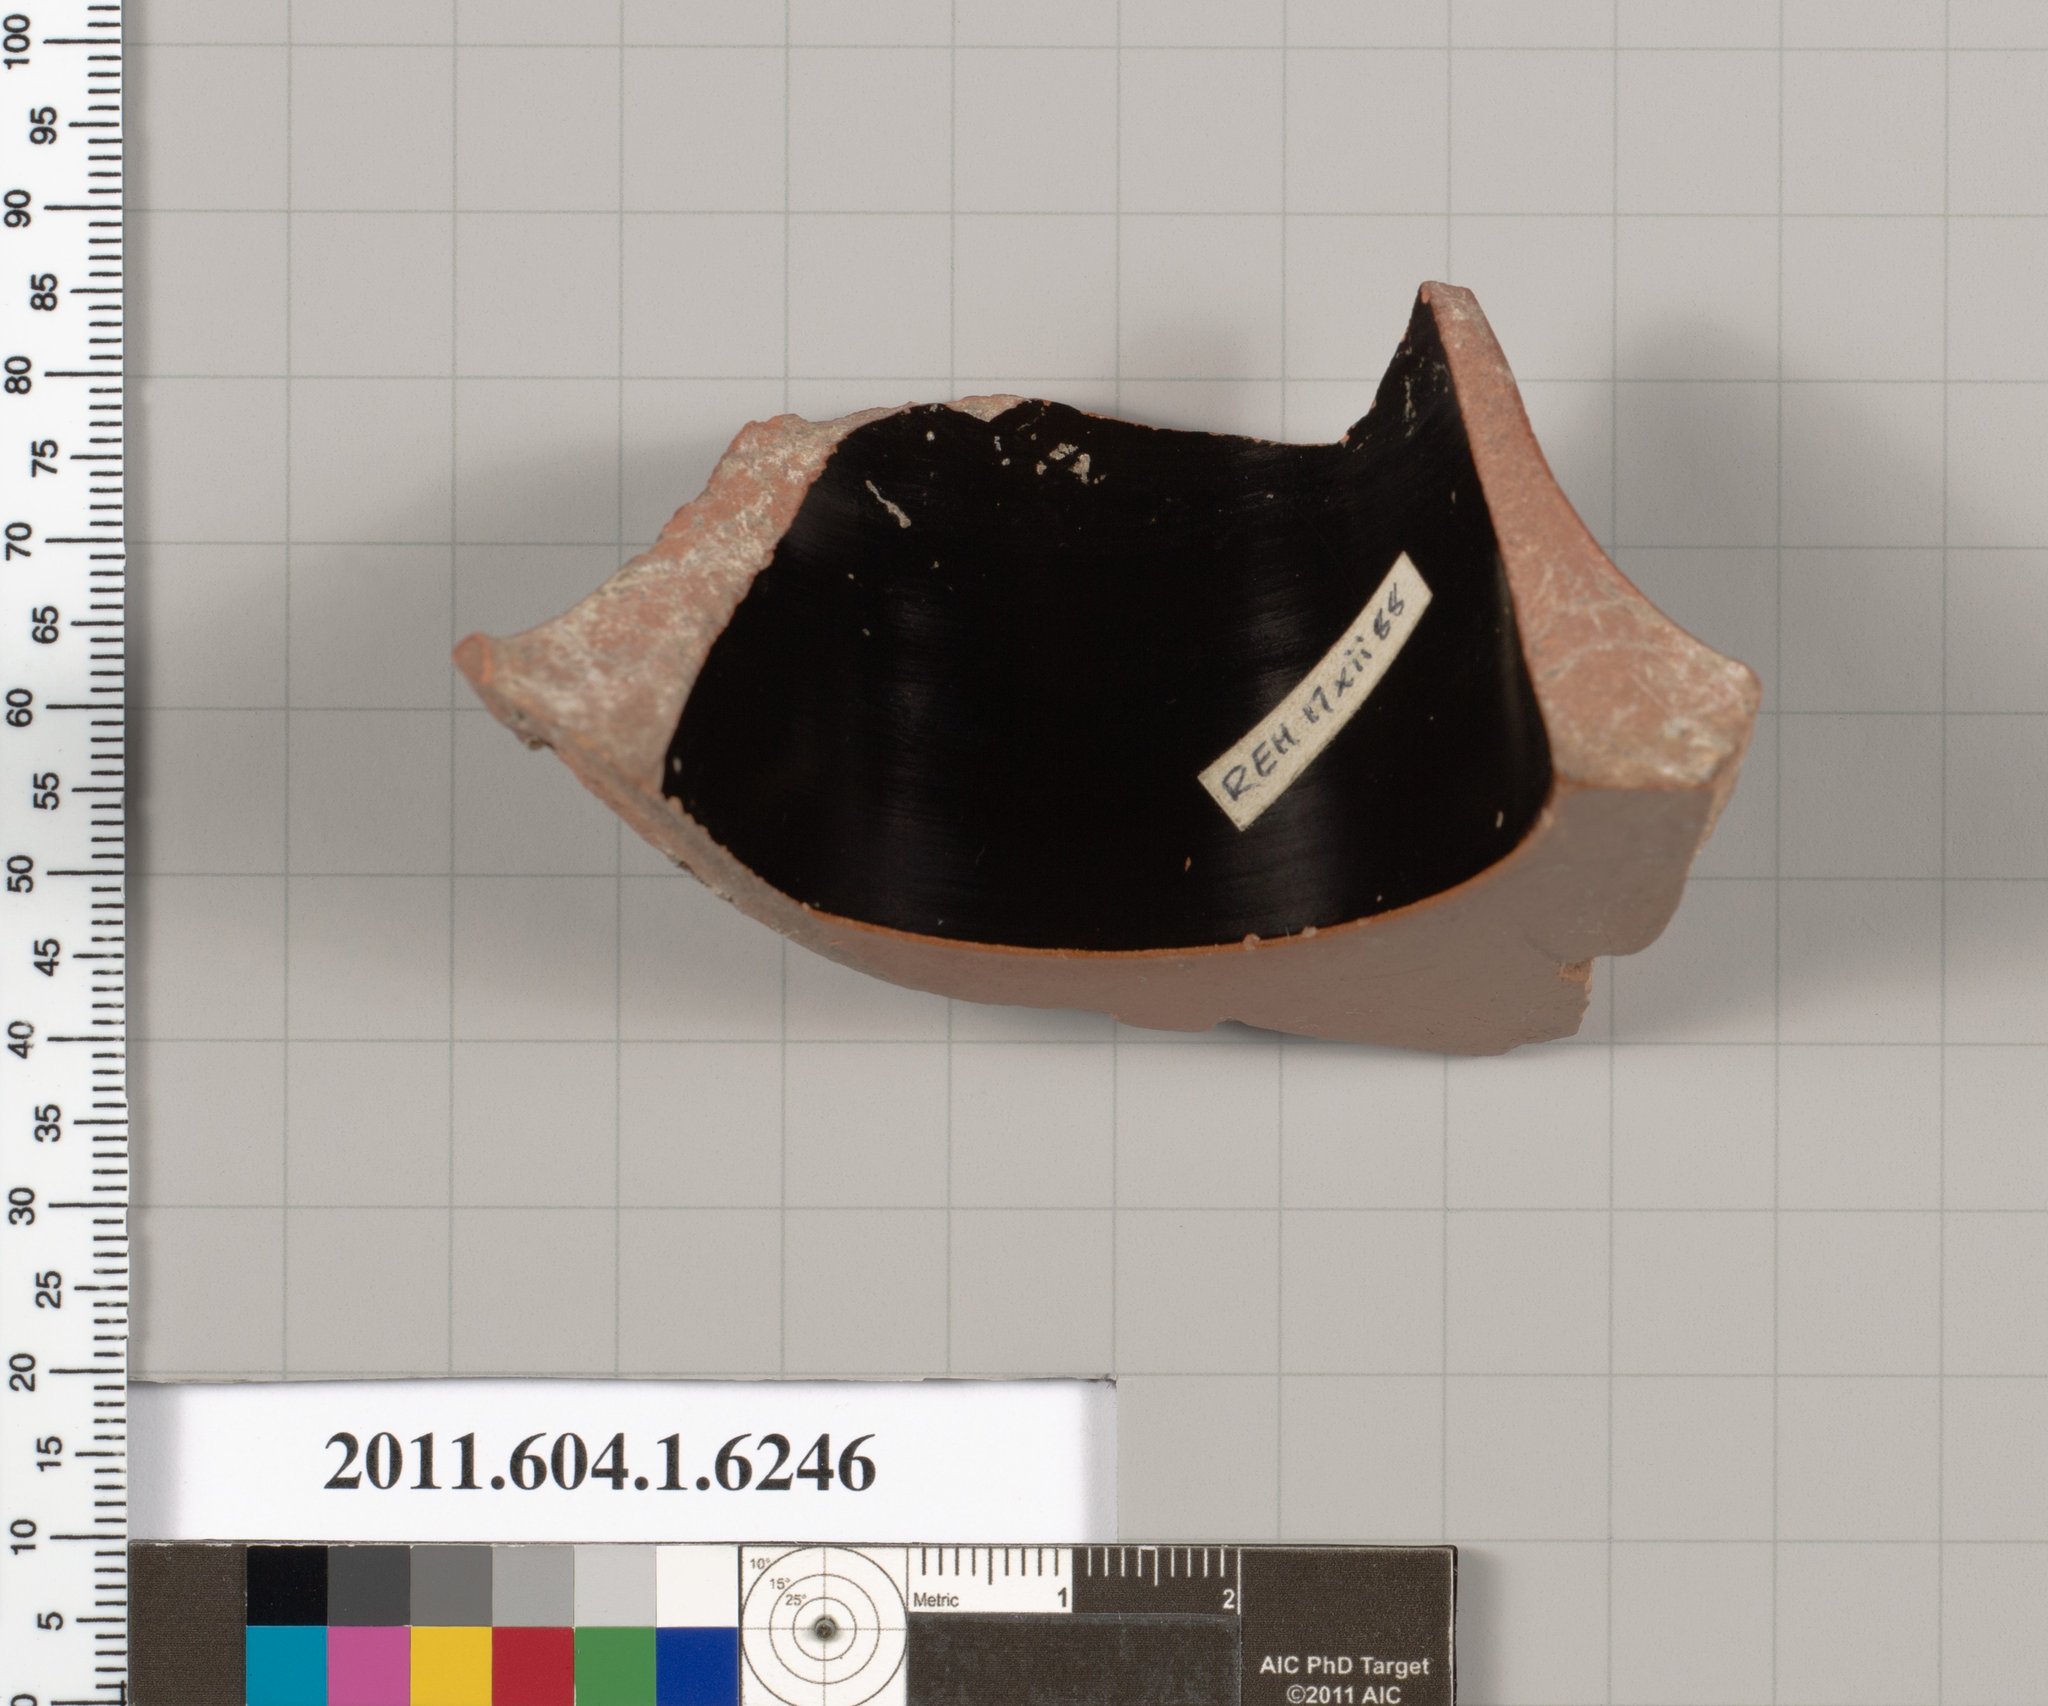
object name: kylix fragment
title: Terracotta fragment of a kylix (drinking cup)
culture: greek, attic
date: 534-468 BCE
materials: terracotta